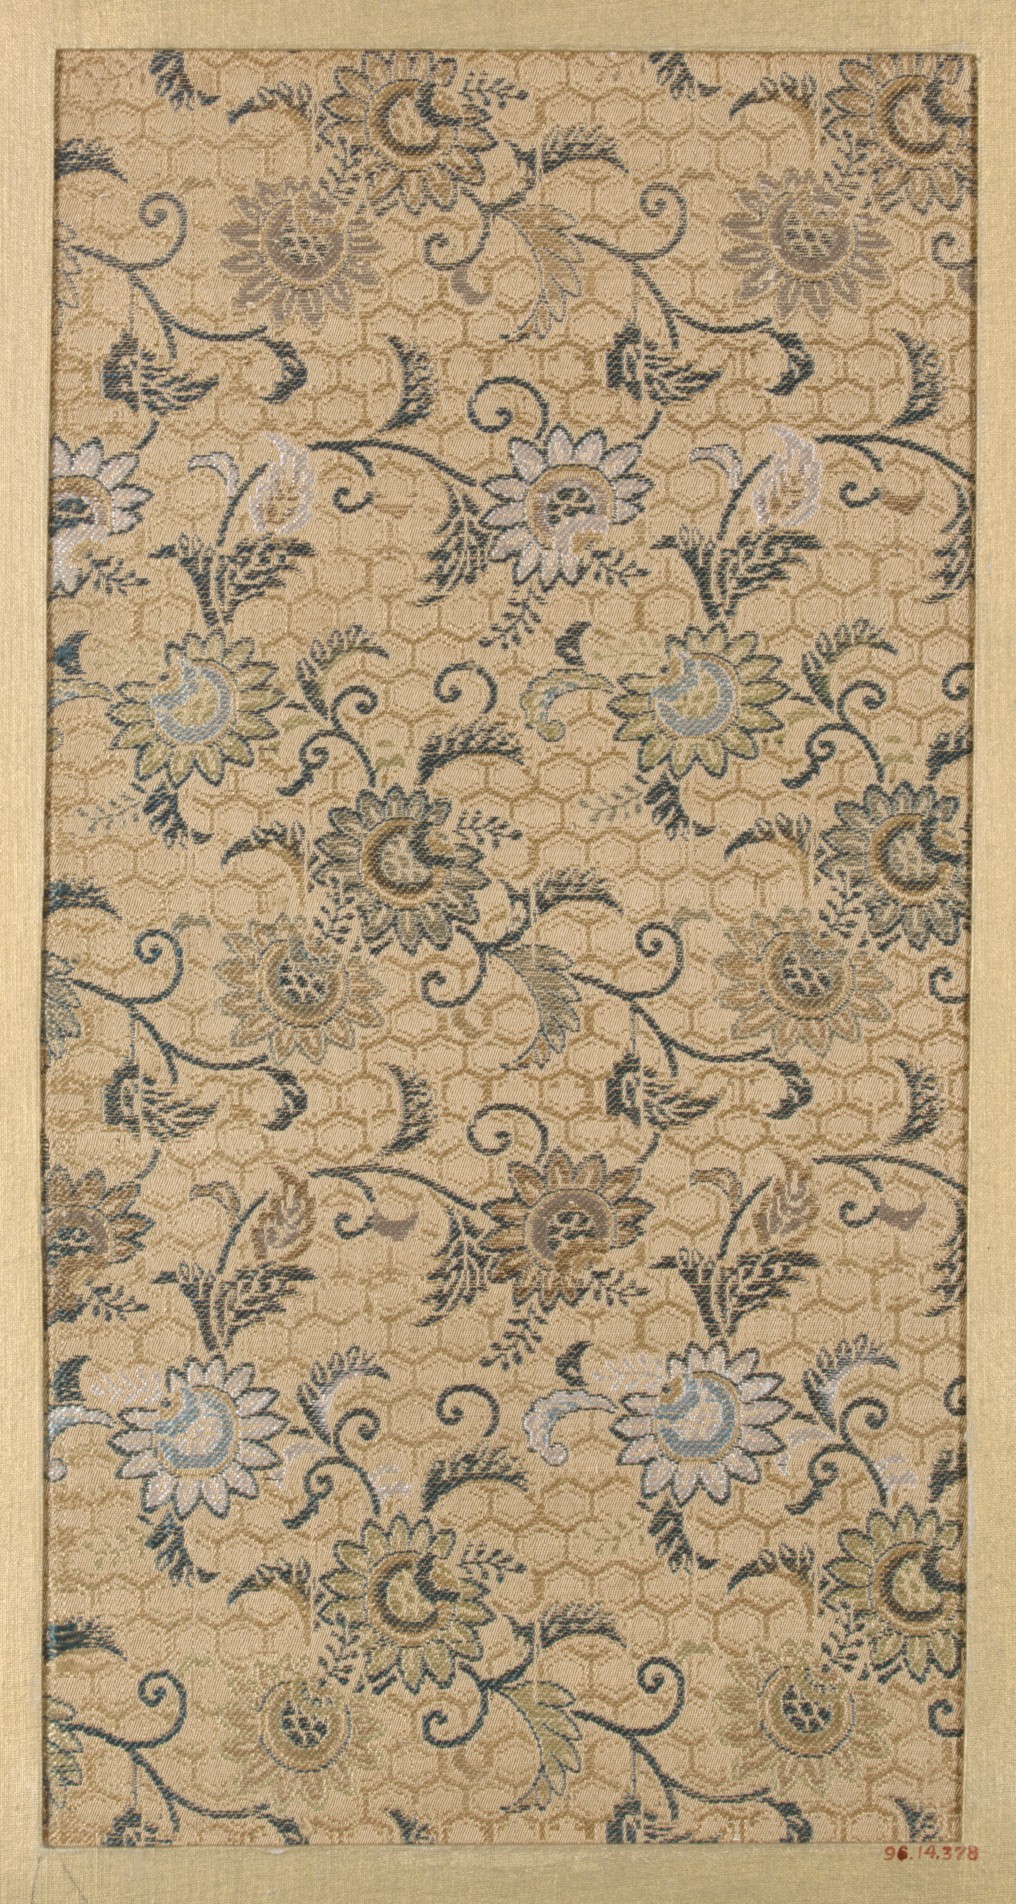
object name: piece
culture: japanese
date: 1701-1900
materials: silk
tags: leaves